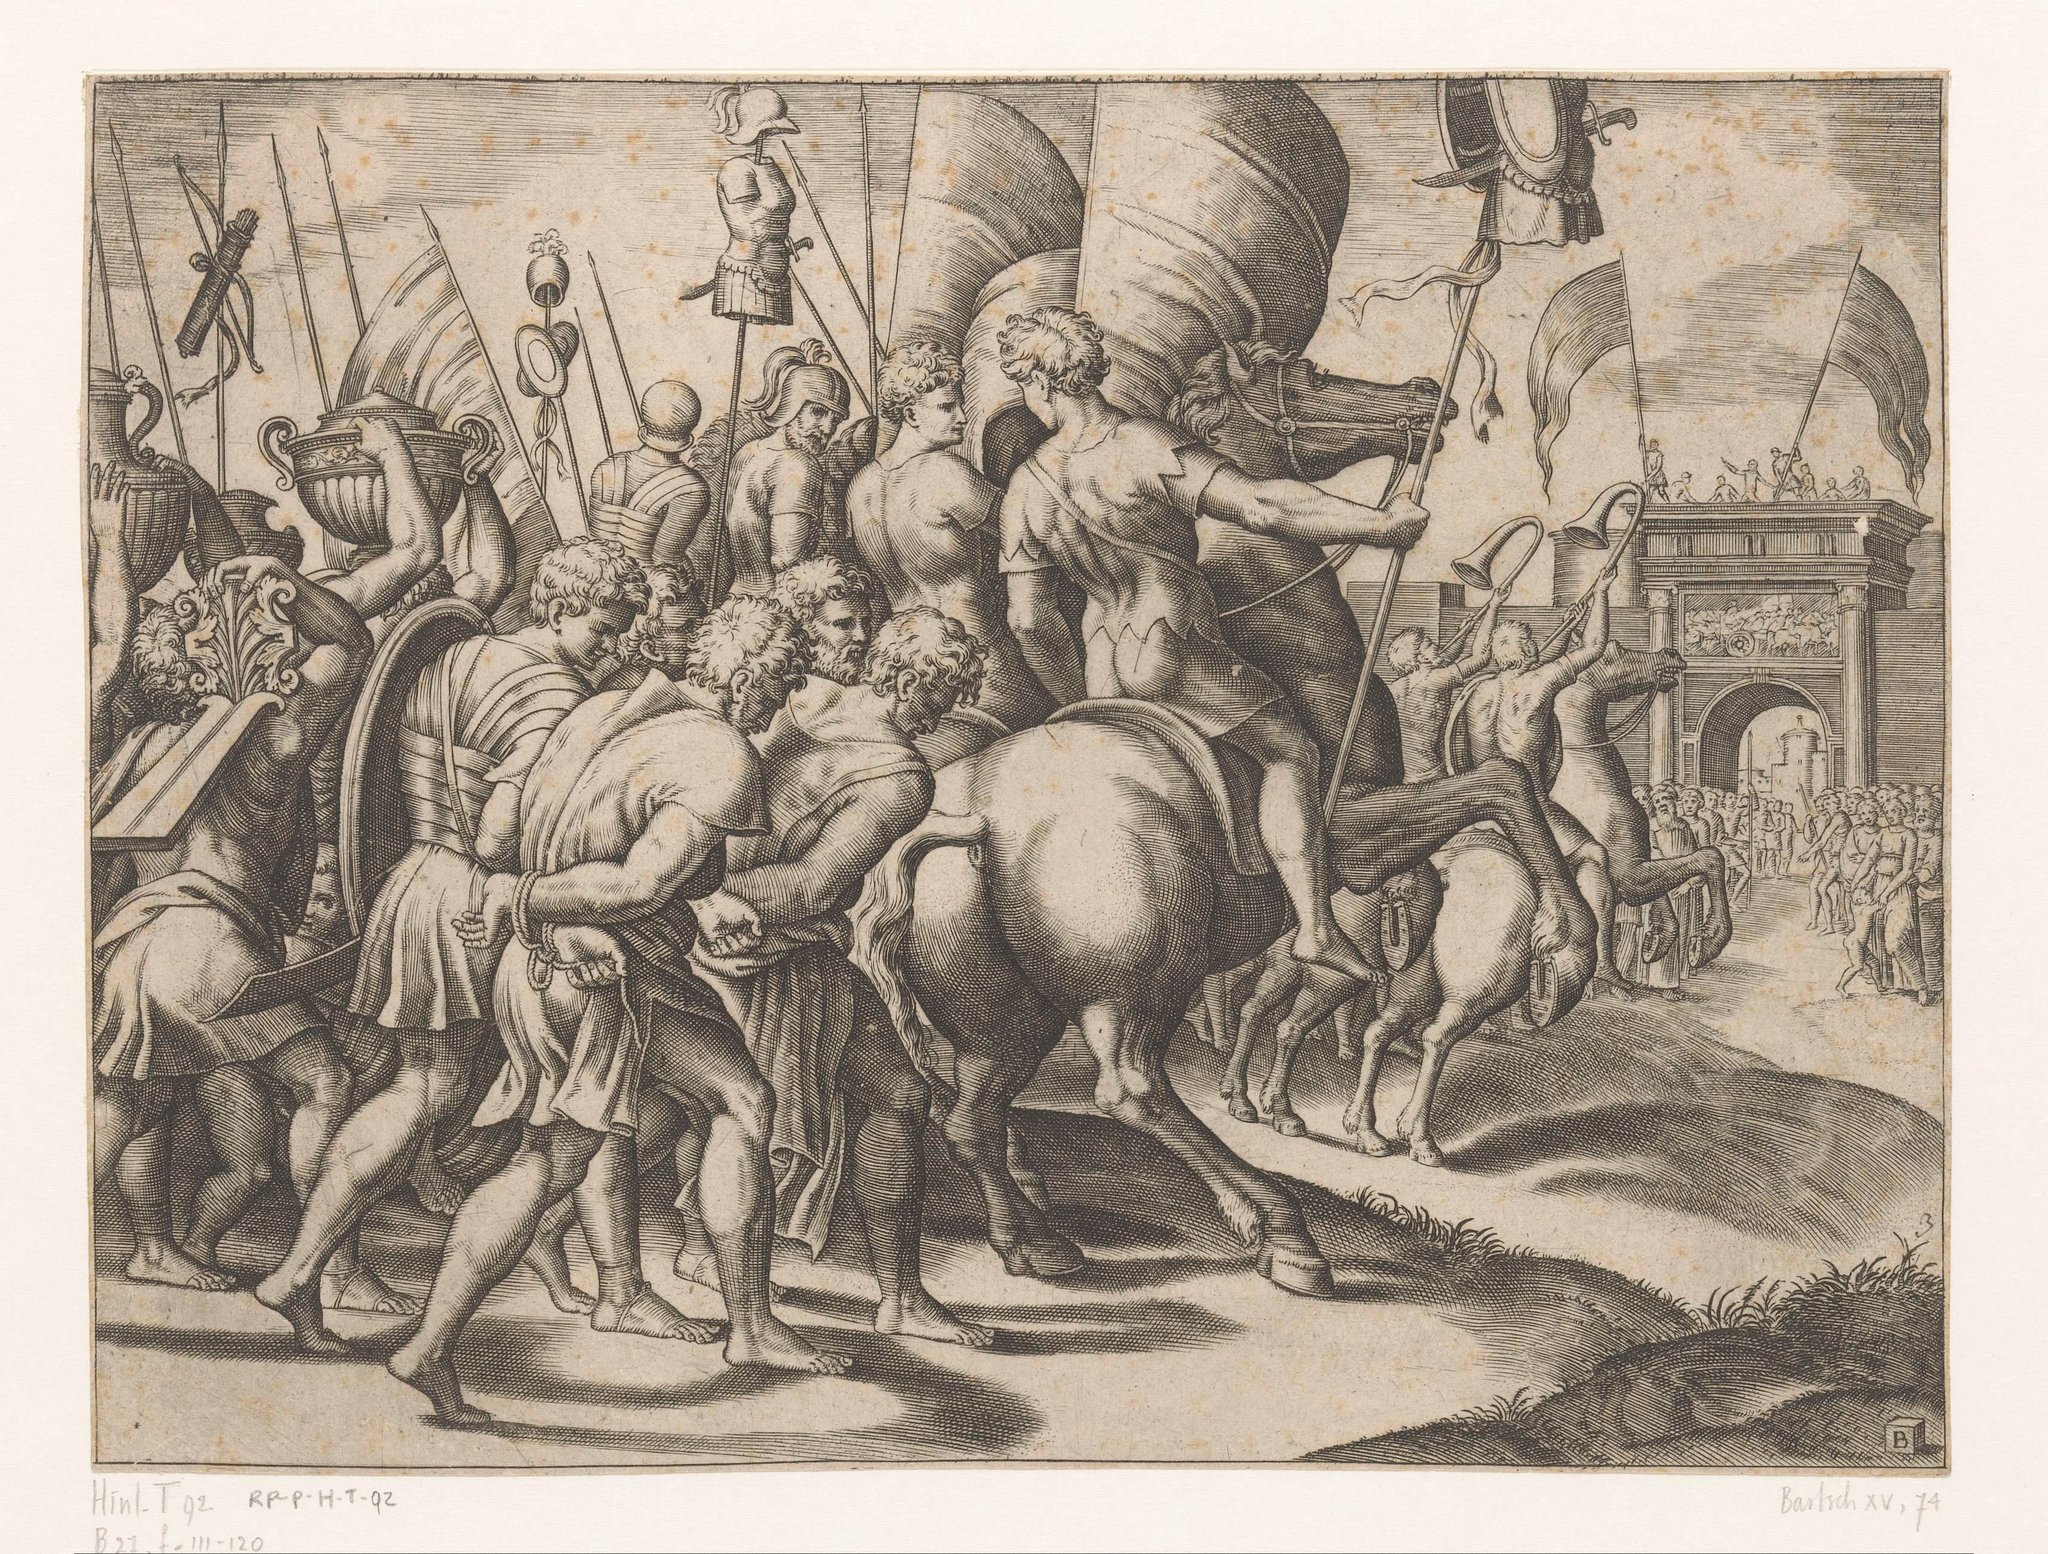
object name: print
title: Triomf van Scipio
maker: meester van de dobbelsteen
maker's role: print maker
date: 1530-1560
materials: paper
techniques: engraving, intaglio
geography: italy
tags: triumph of scipio, triumphal arch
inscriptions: collector's mark: ‘Hinloopen’, collector's mark: Lugt 10, collector's mark: Lugt 11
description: Triomfoptocht van Scipio Africanus in Rome na zijn overwinning op het Carthaagse leger. Achter de overwinnaars te paard lopen de geketende overwonnenen. Rechts een triomfboog.